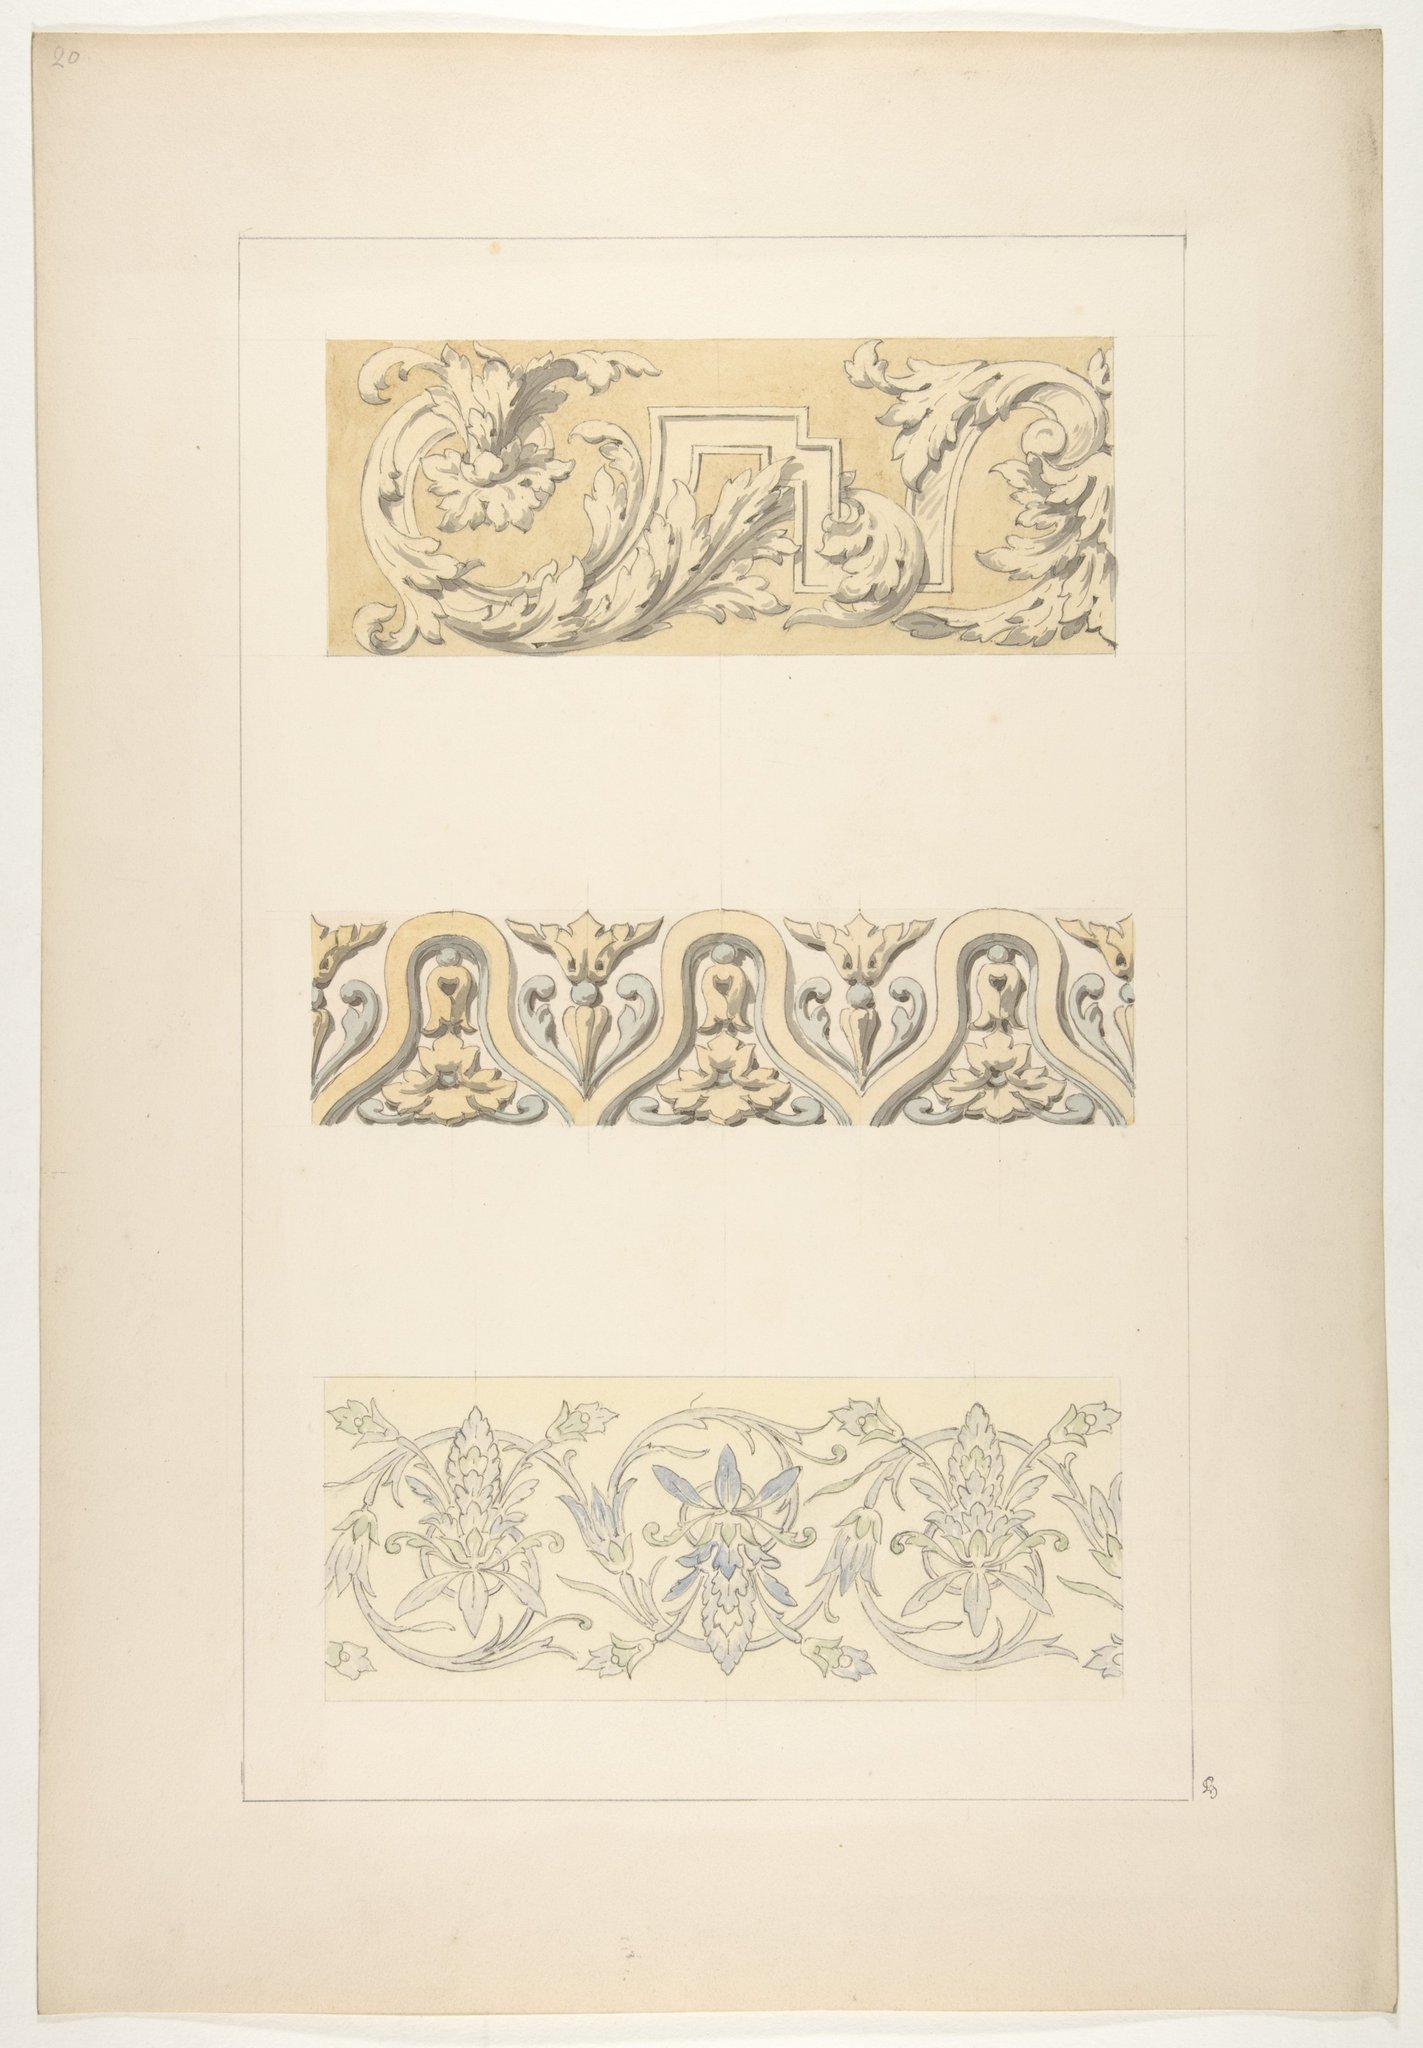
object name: drawing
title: Three designs for decorative borders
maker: jules-edmond-charles lachaise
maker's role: artist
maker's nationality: french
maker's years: 1897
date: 1830-1897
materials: graphite, ink, watercolor, paper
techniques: pen, wash